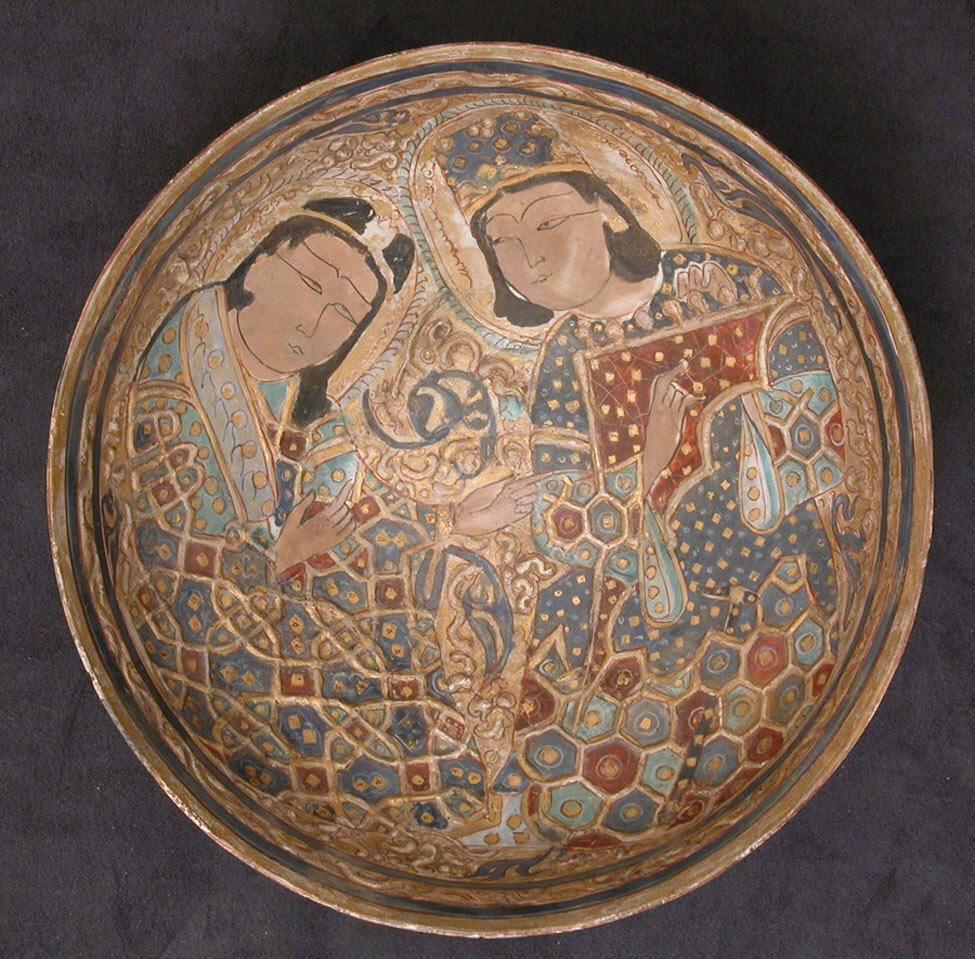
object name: bowl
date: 1101-1300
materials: stonepaste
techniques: overglaze, painting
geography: iran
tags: human figures